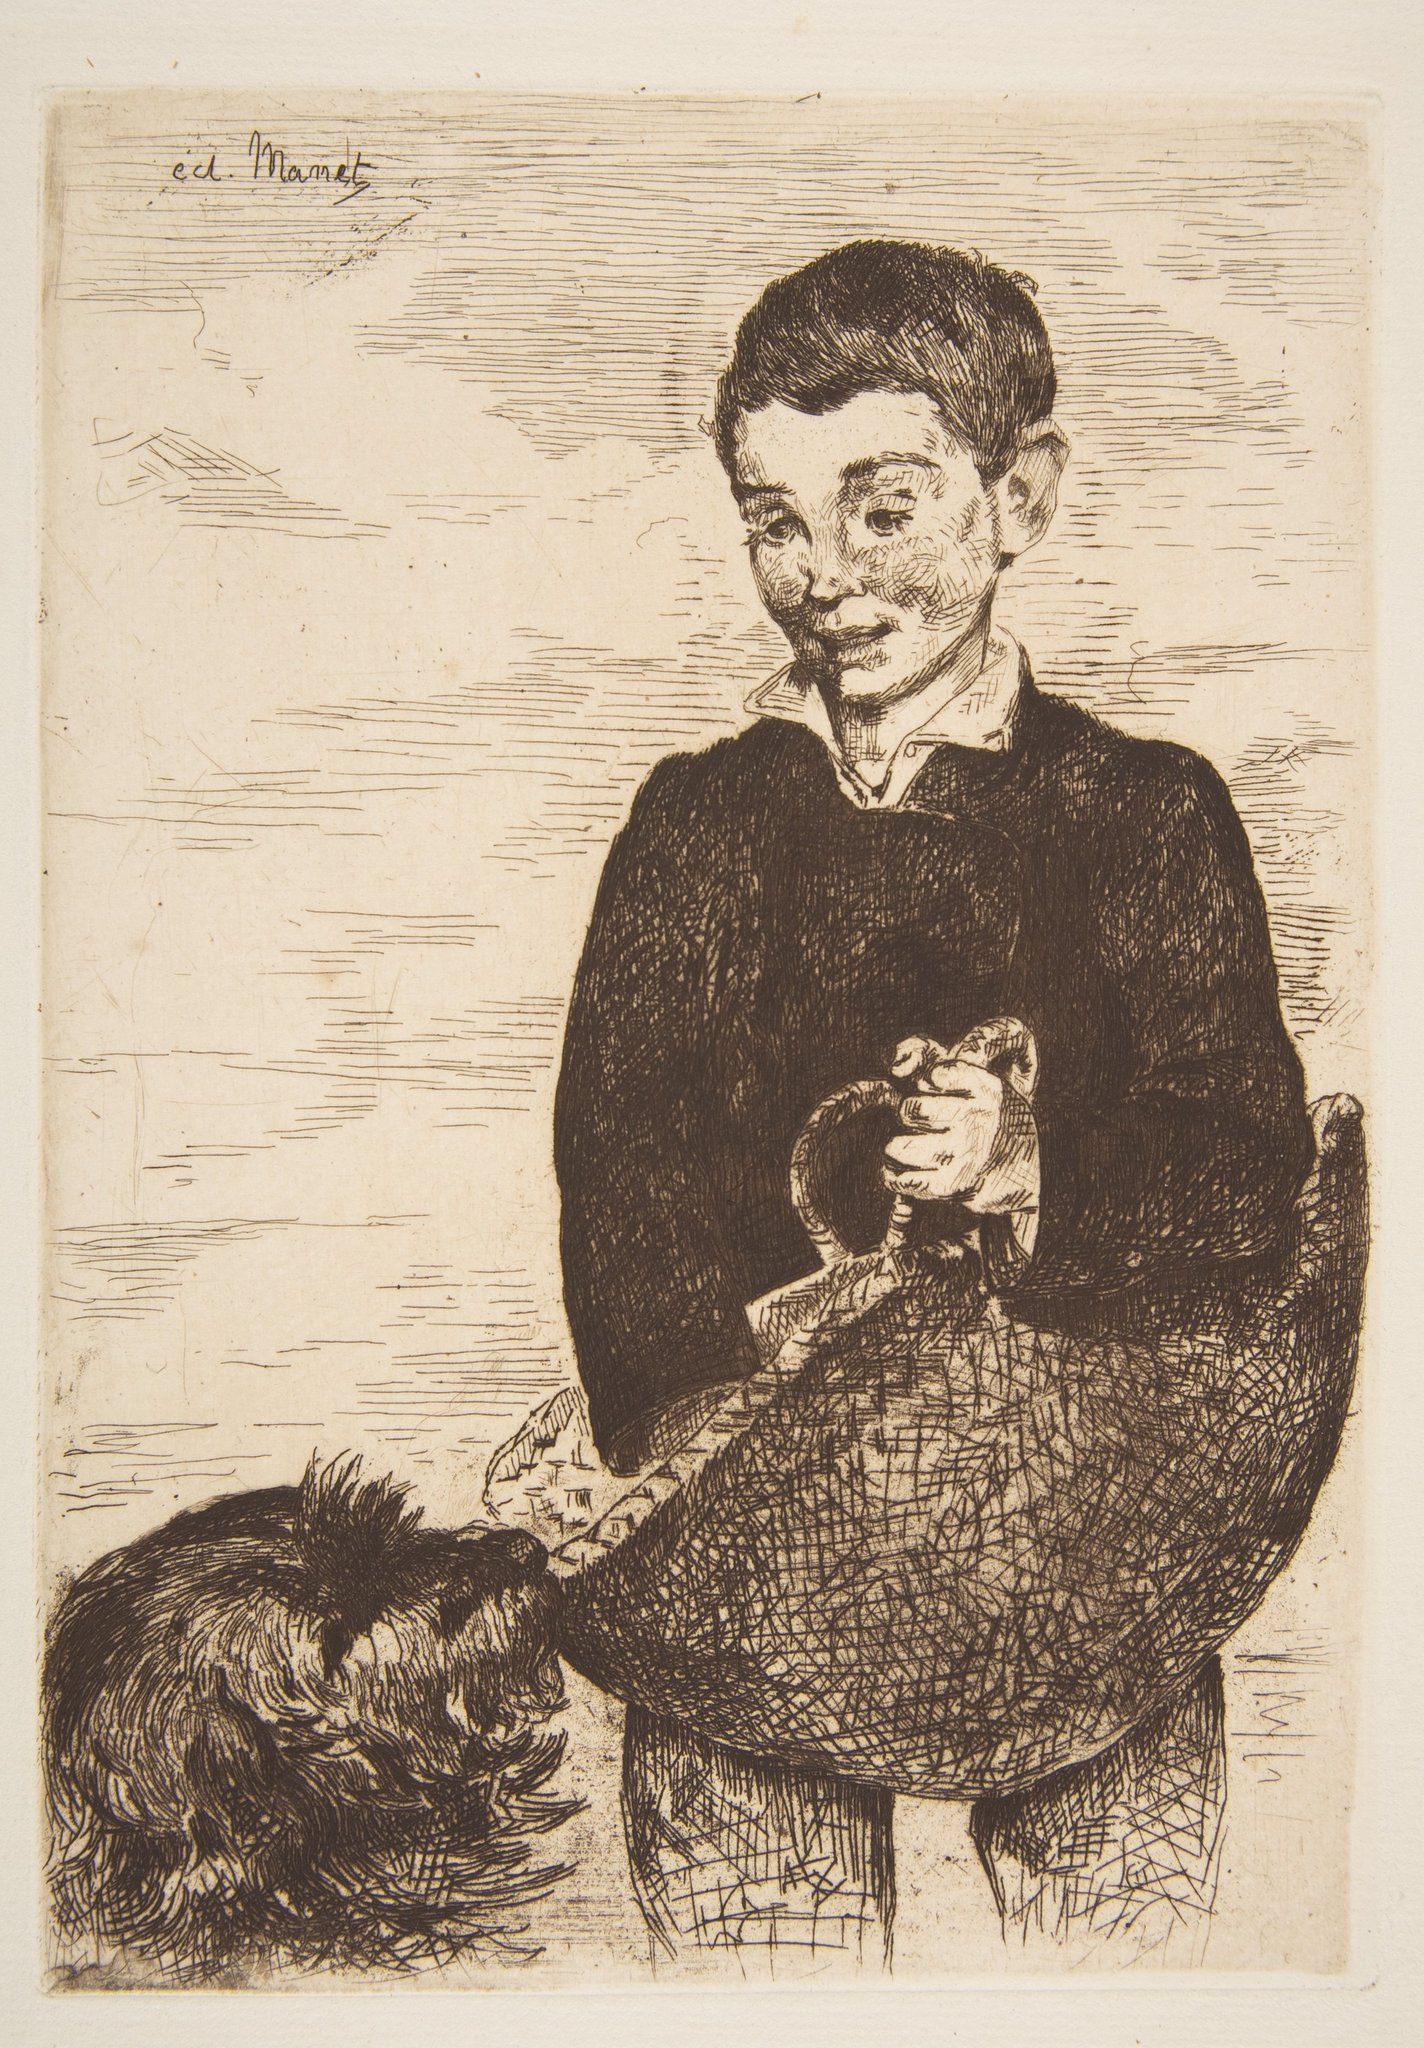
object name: print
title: The Urchin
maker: édouard manet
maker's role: artist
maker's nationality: french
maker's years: 1832-1883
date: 1861-1862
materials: ink, paper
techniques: etching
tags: boys,dogs